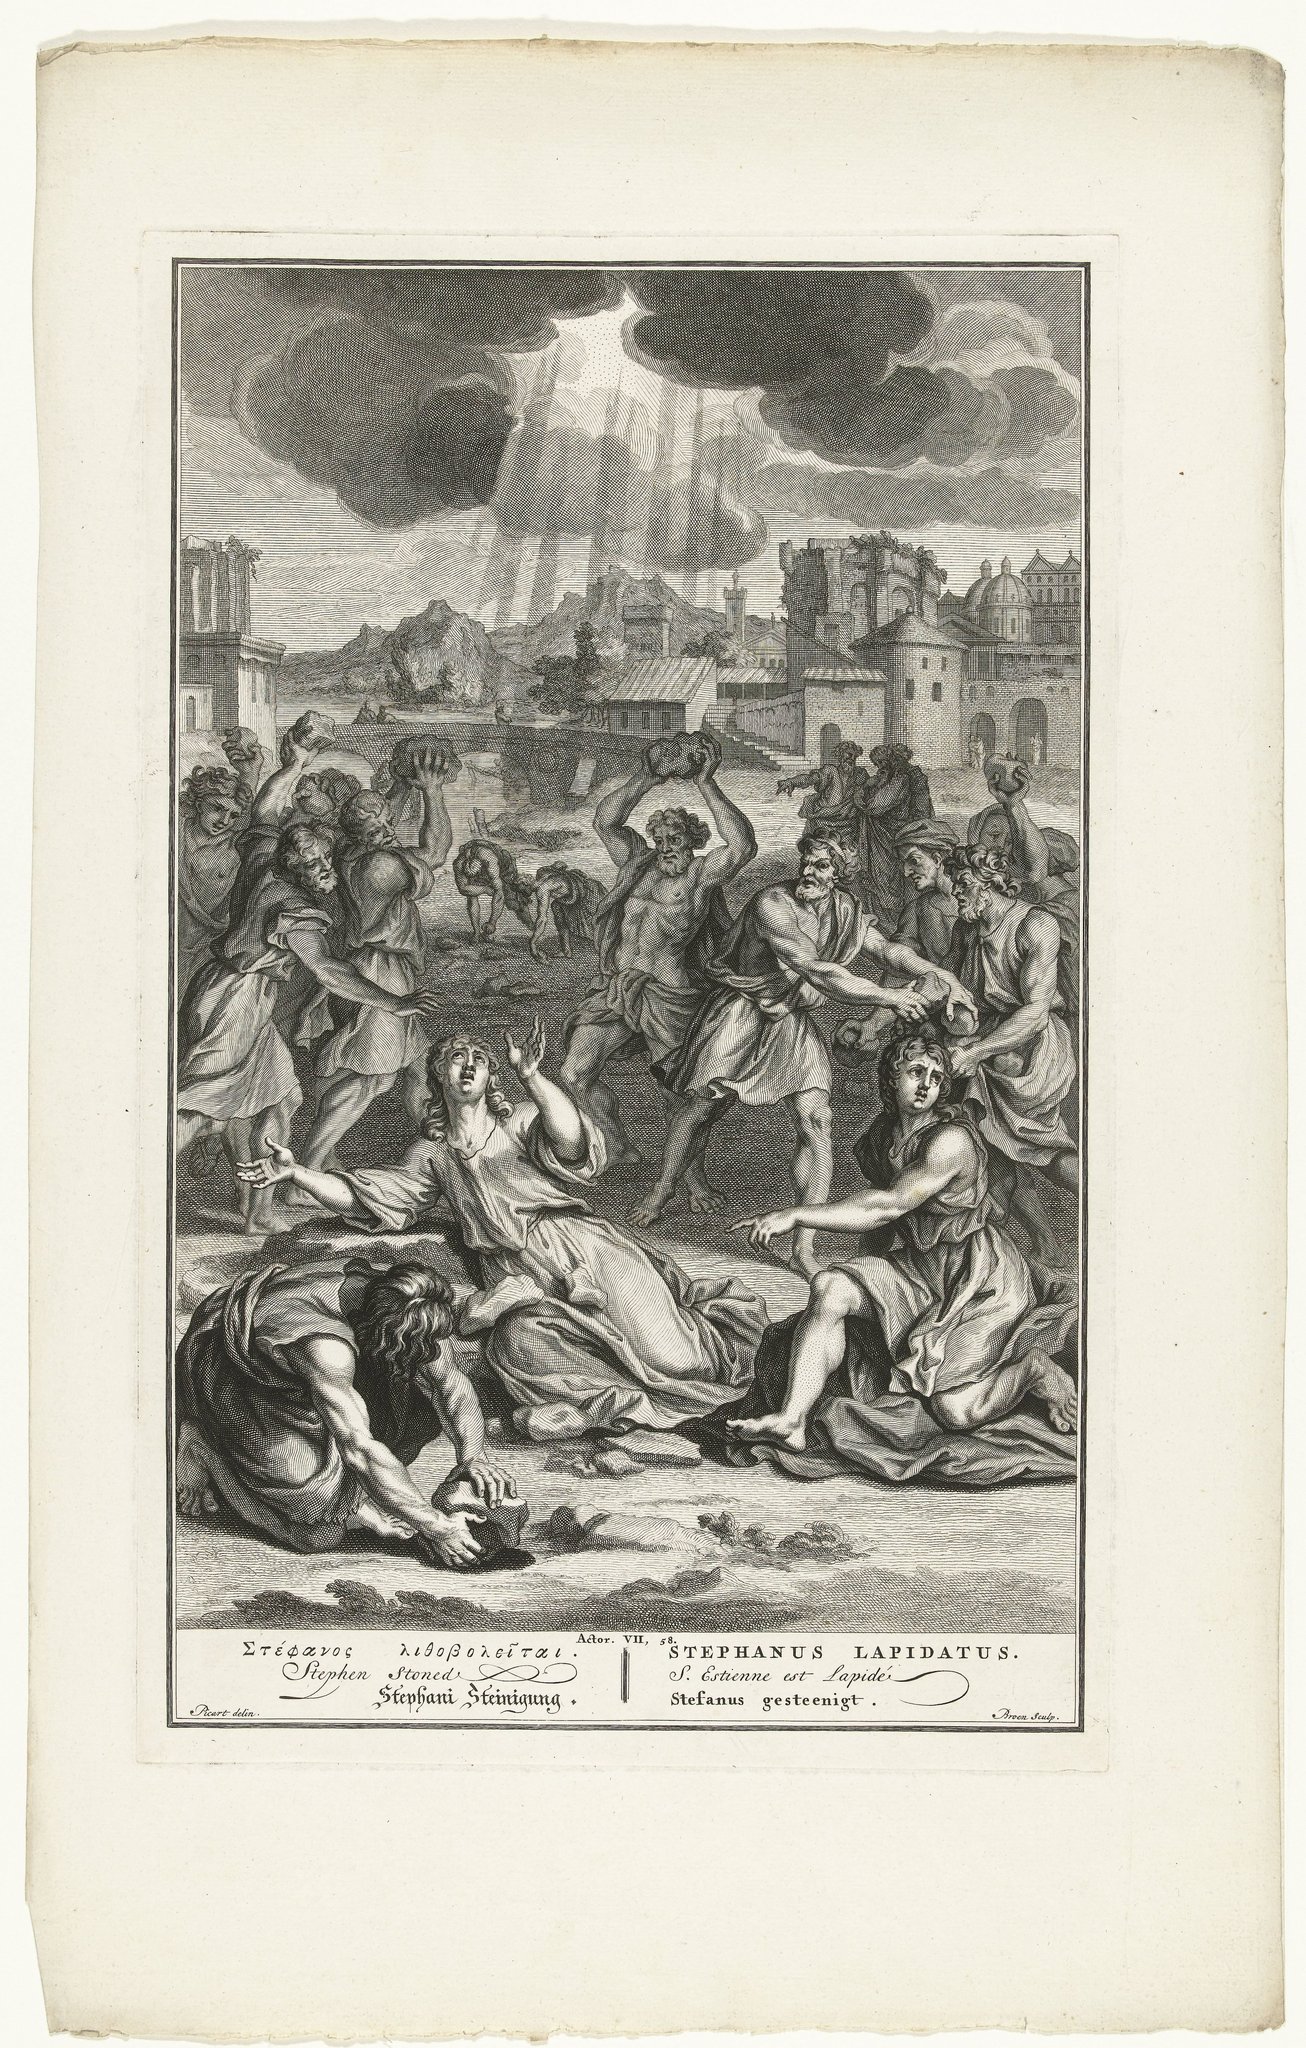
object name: print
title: Steniging van Stefanus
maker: bernard picart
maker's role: draughtsman, print maker, publisher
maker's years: 1673-1733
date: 1711-1720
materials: paper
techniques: engraving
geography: amsterdam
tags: the stoning of stephen; the witnesses lay down their clothes at saul's feet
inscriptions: inscription: ‘Utrechts Fundatie huys’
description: Nadat Stefanus van zijn visioen van Christus heeft verteld, wordt hij de stad uitgegooid en door de woedende menigte gestenigd. Illustratie voor het Nieuwe Testament, Hand. 7, 58. Onder de voorstelling een titel in het Grieks, Engels, Duits, Latijn, Frans en Nederlands.